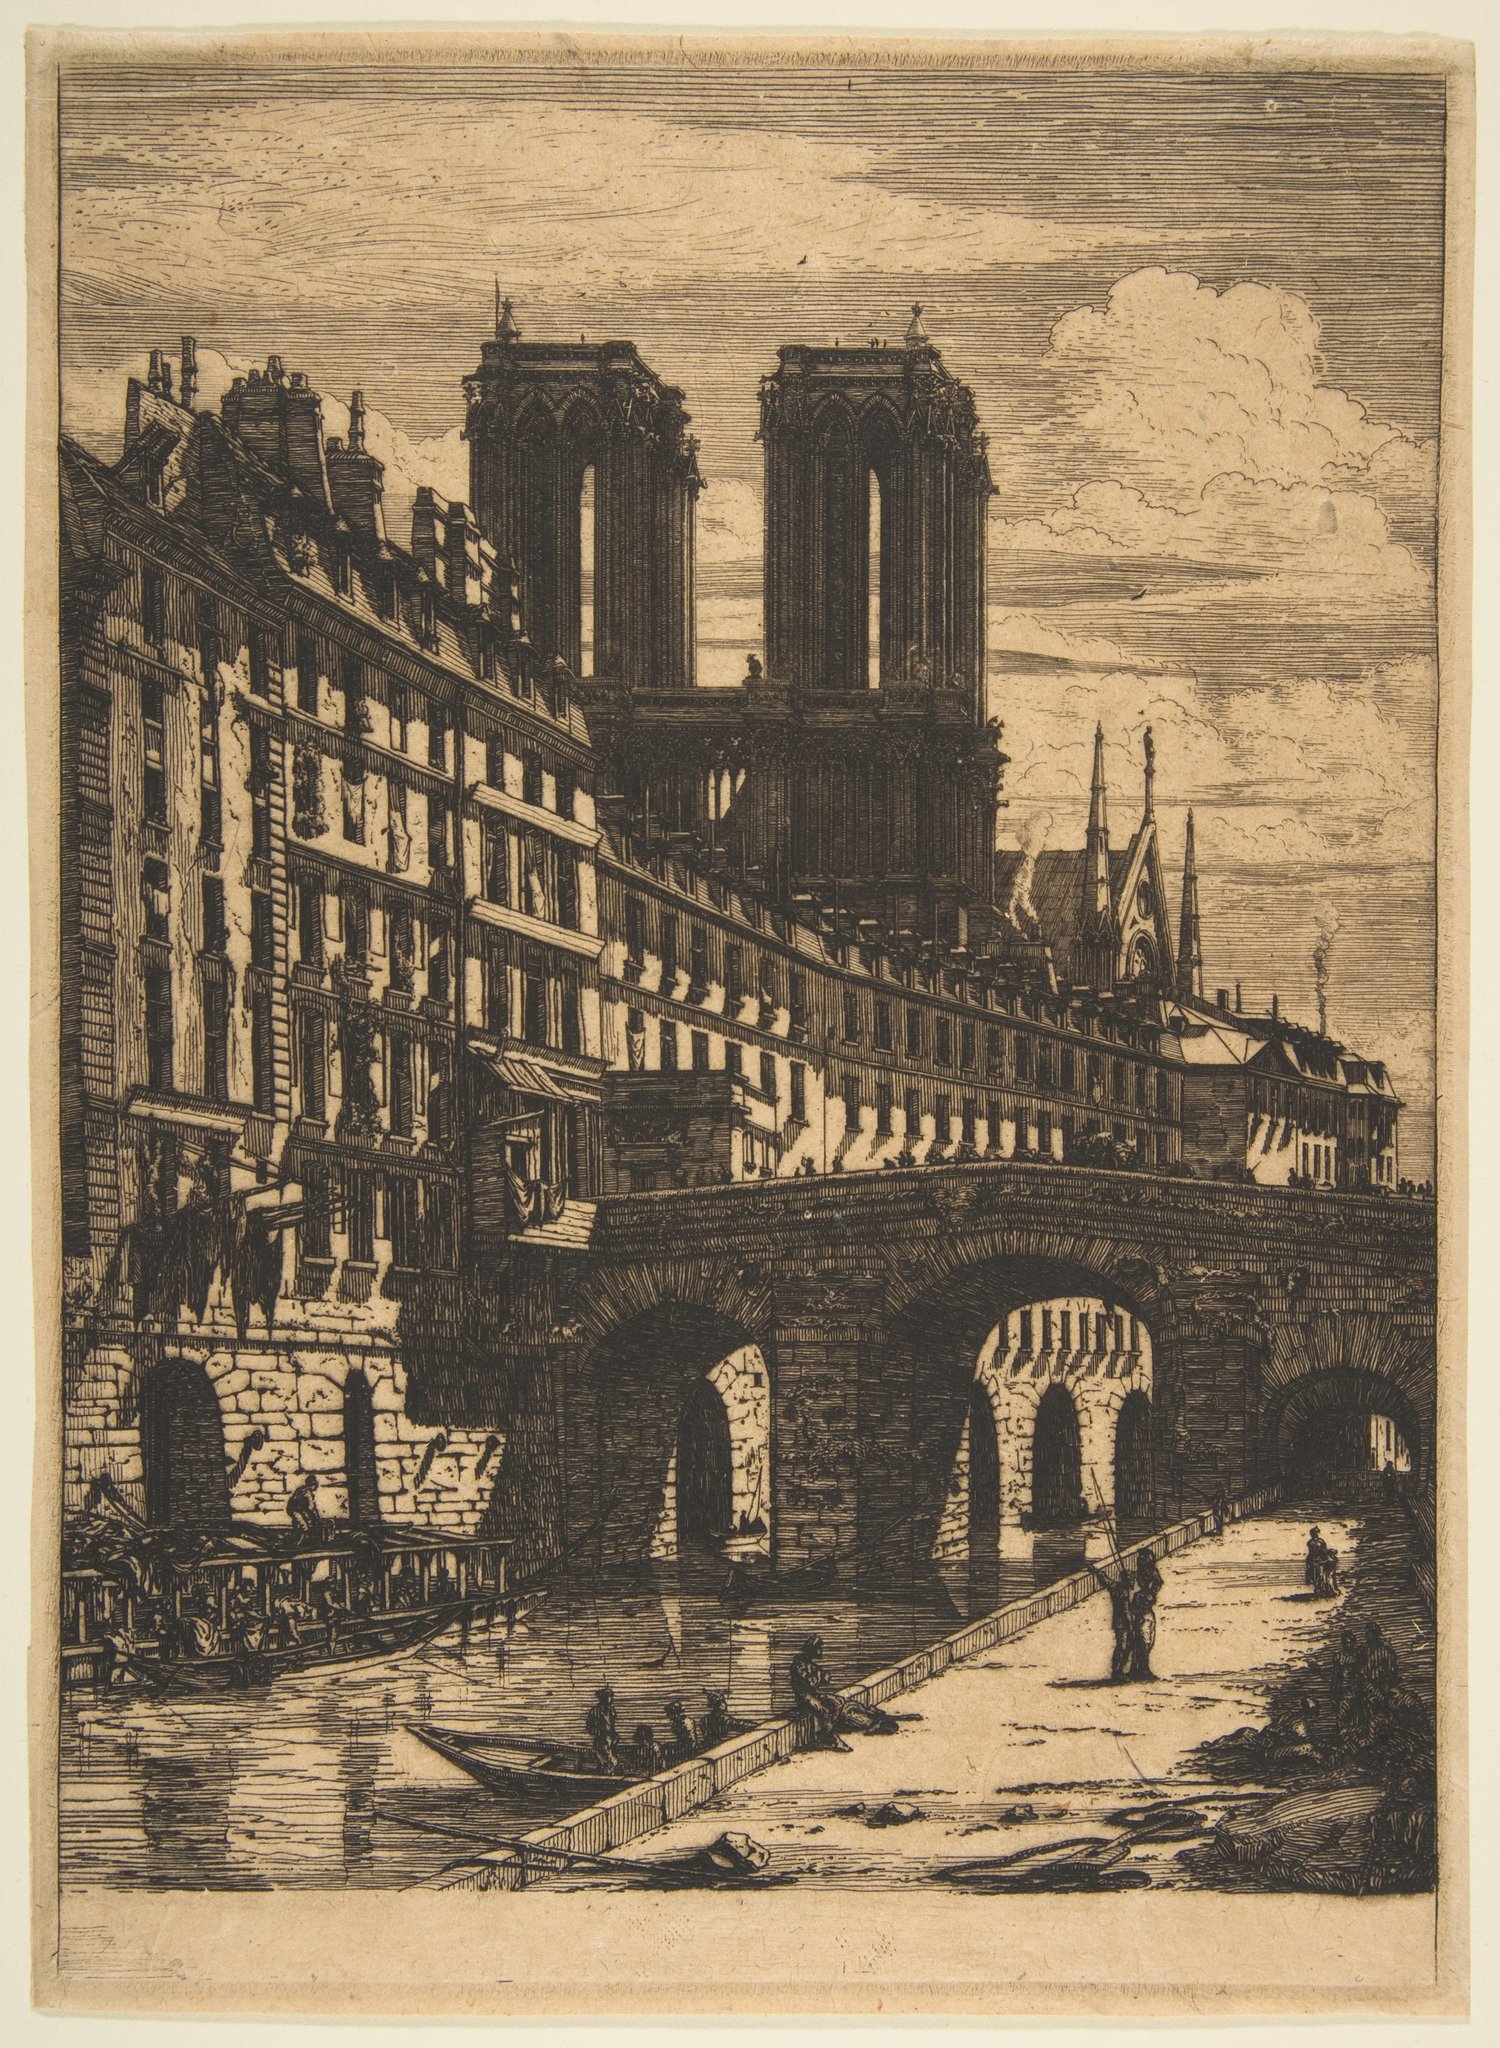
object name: print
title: The Petit Pont, Paris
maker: charles meryon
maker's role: artist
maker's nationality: french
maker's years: 1821-1868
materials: paper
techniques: engraving, etching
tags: buildings,bridges,boats,paris